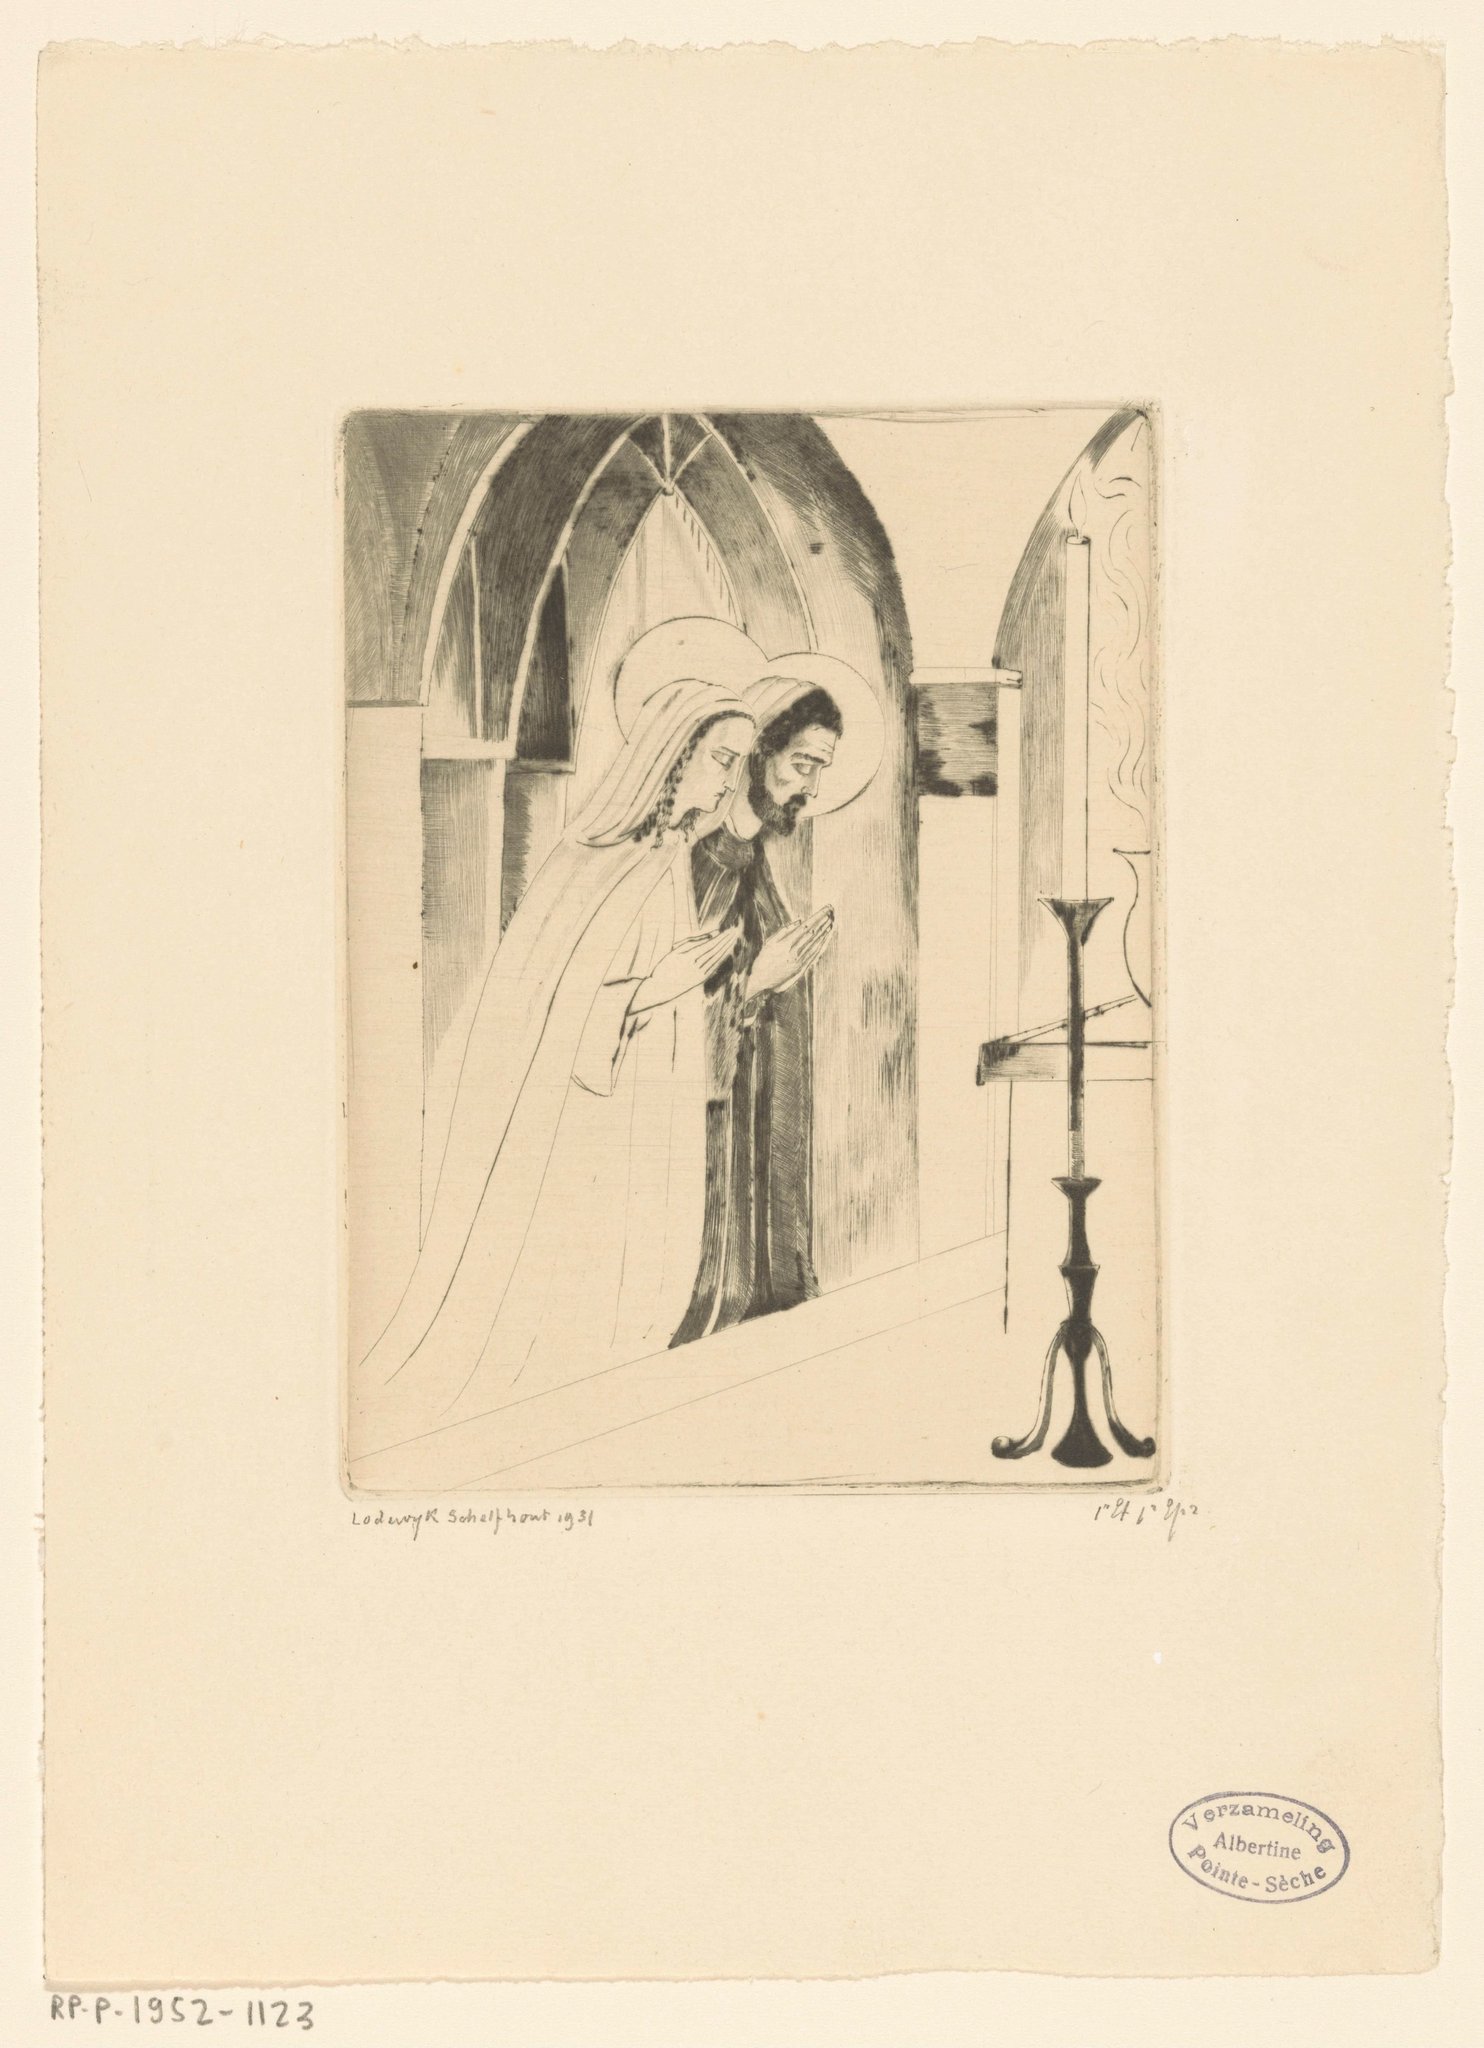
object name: print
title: Huwelijk van Maria en Jozef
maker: lodewijk schelfhout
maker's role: draughtsman, print maker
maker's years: 1881-1943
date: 1931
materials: paper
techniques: drypoint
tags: marriage of mary and joseph, 'sposalizio': they are married by the high priest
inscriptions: collector's mark: Lugt 2228, collector's mark: Lugt 5i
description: Maria en Jozef met samengevouwen handen, knielend bij een altaar in een gebouw met een gotisch gewelf. Rechts op de voorgrond een brandende kaars.